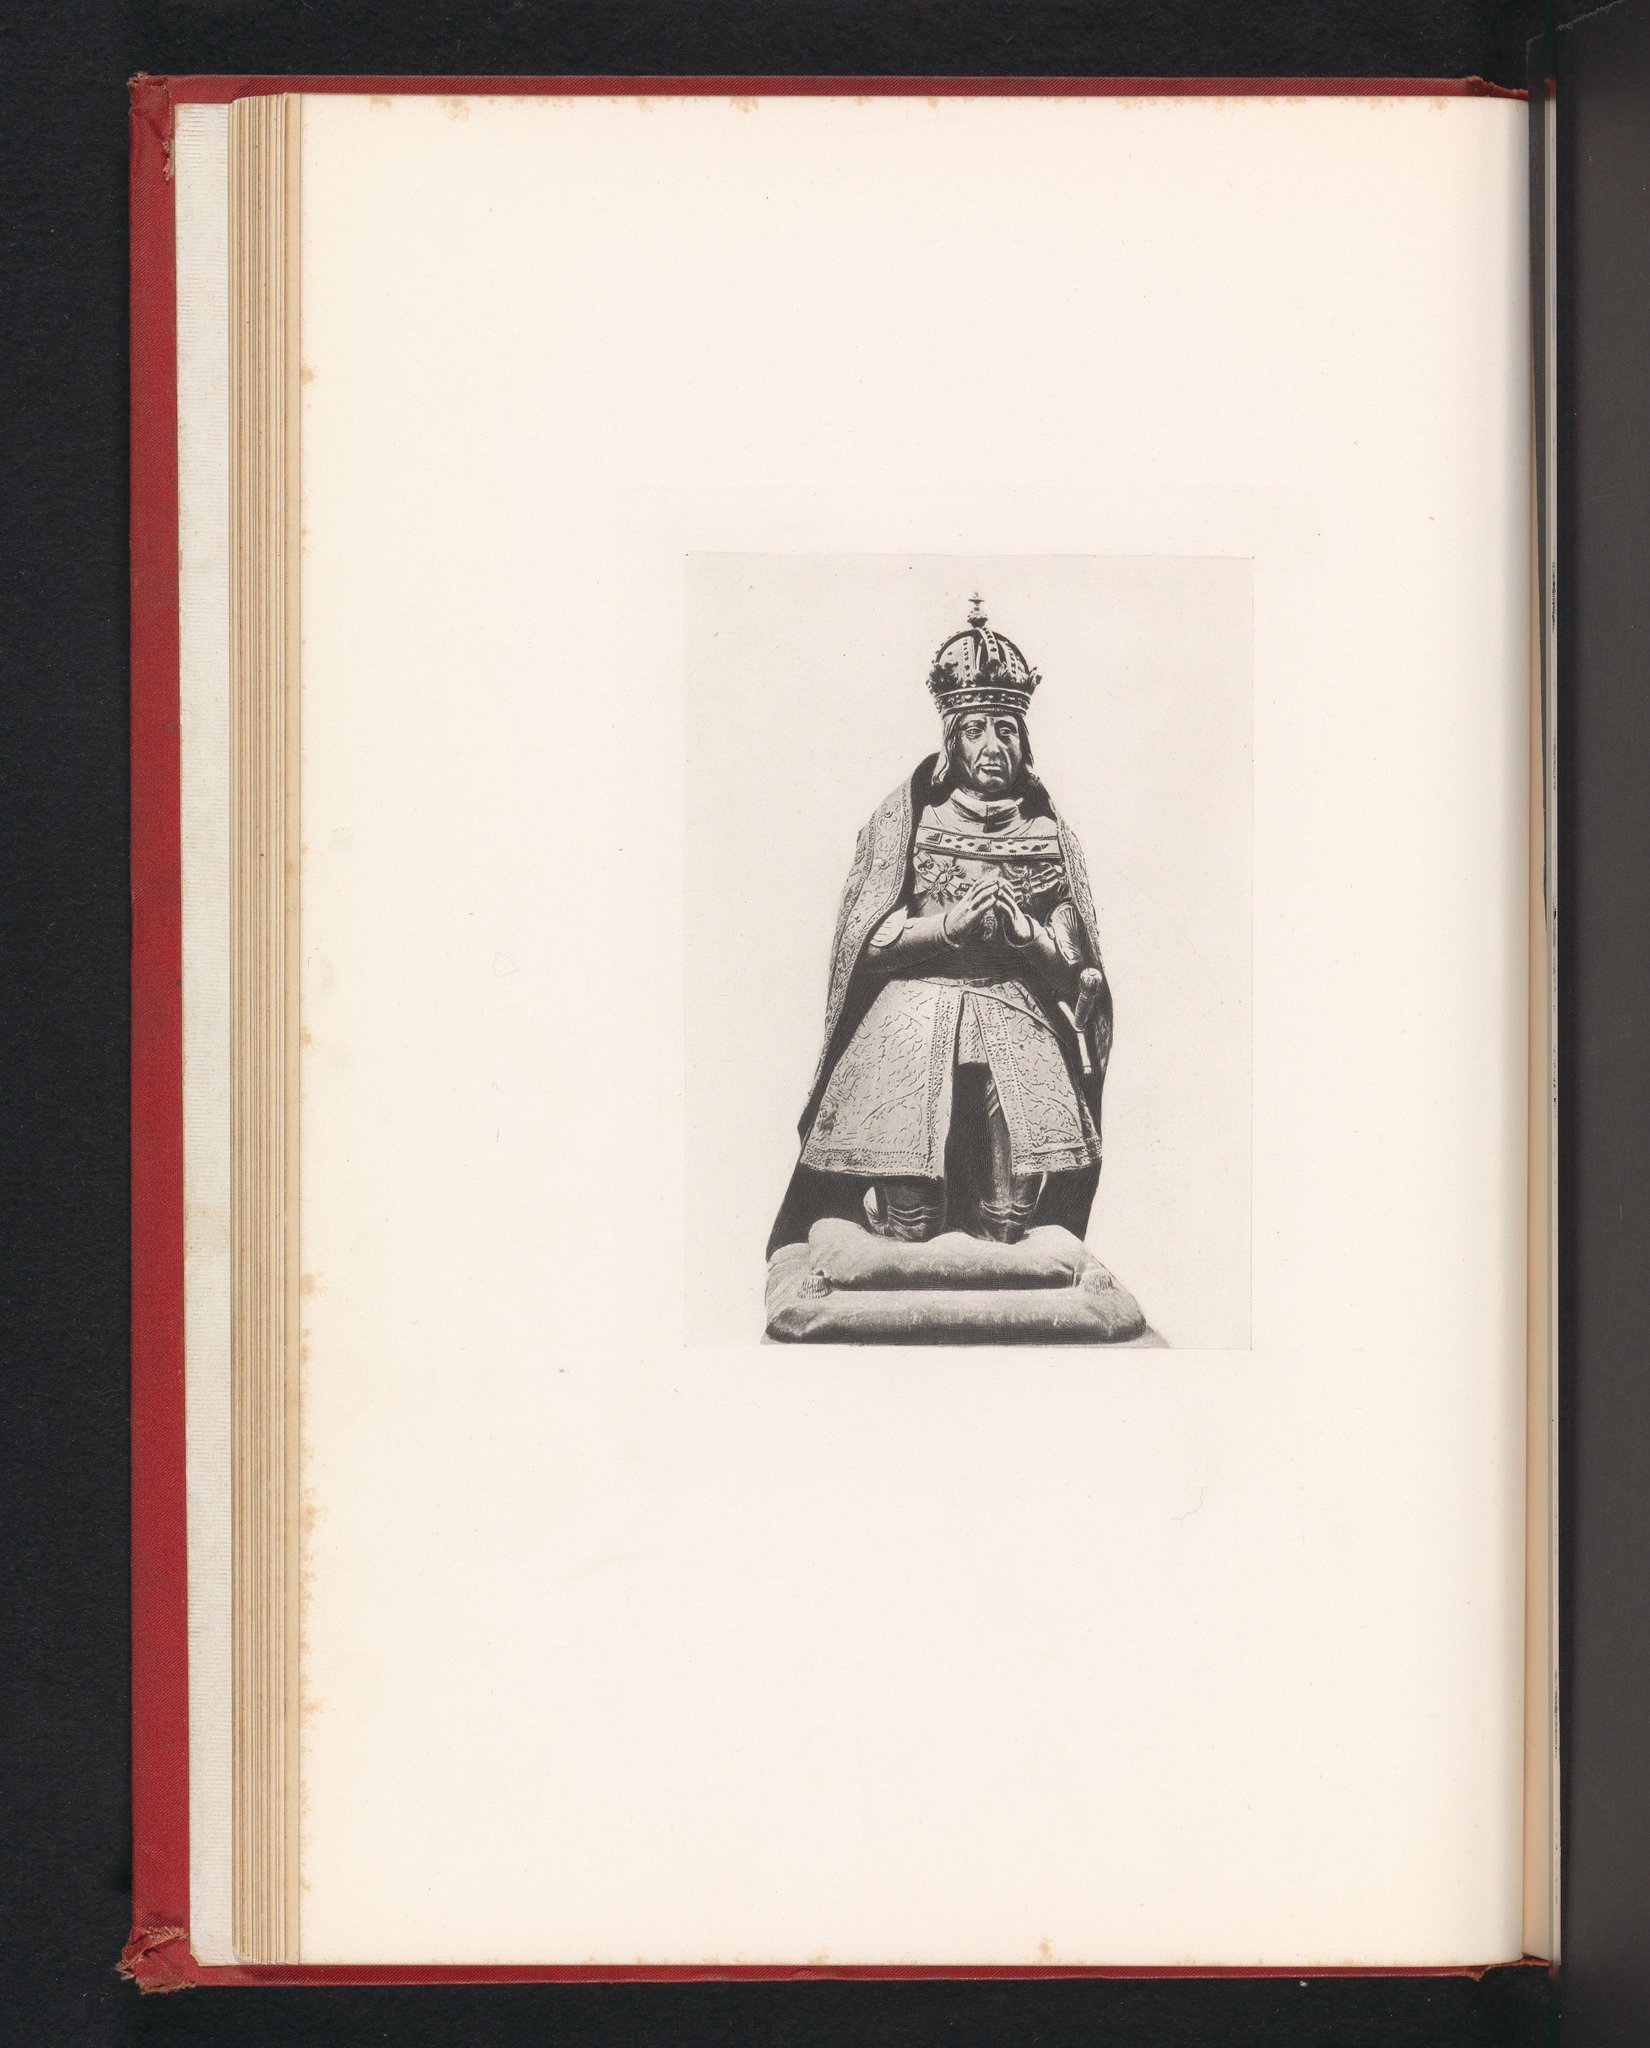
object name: photomechanical print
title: Fotoreproductie van een prent van een sculptuur van keizer Maximiliaan I uit de Hofkerk in Innsbruck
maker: Anonymous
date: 1878-1888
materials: paper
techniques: photoaquatint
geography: philadelphia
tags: maximilian i (holy roman emperor), monument, statue